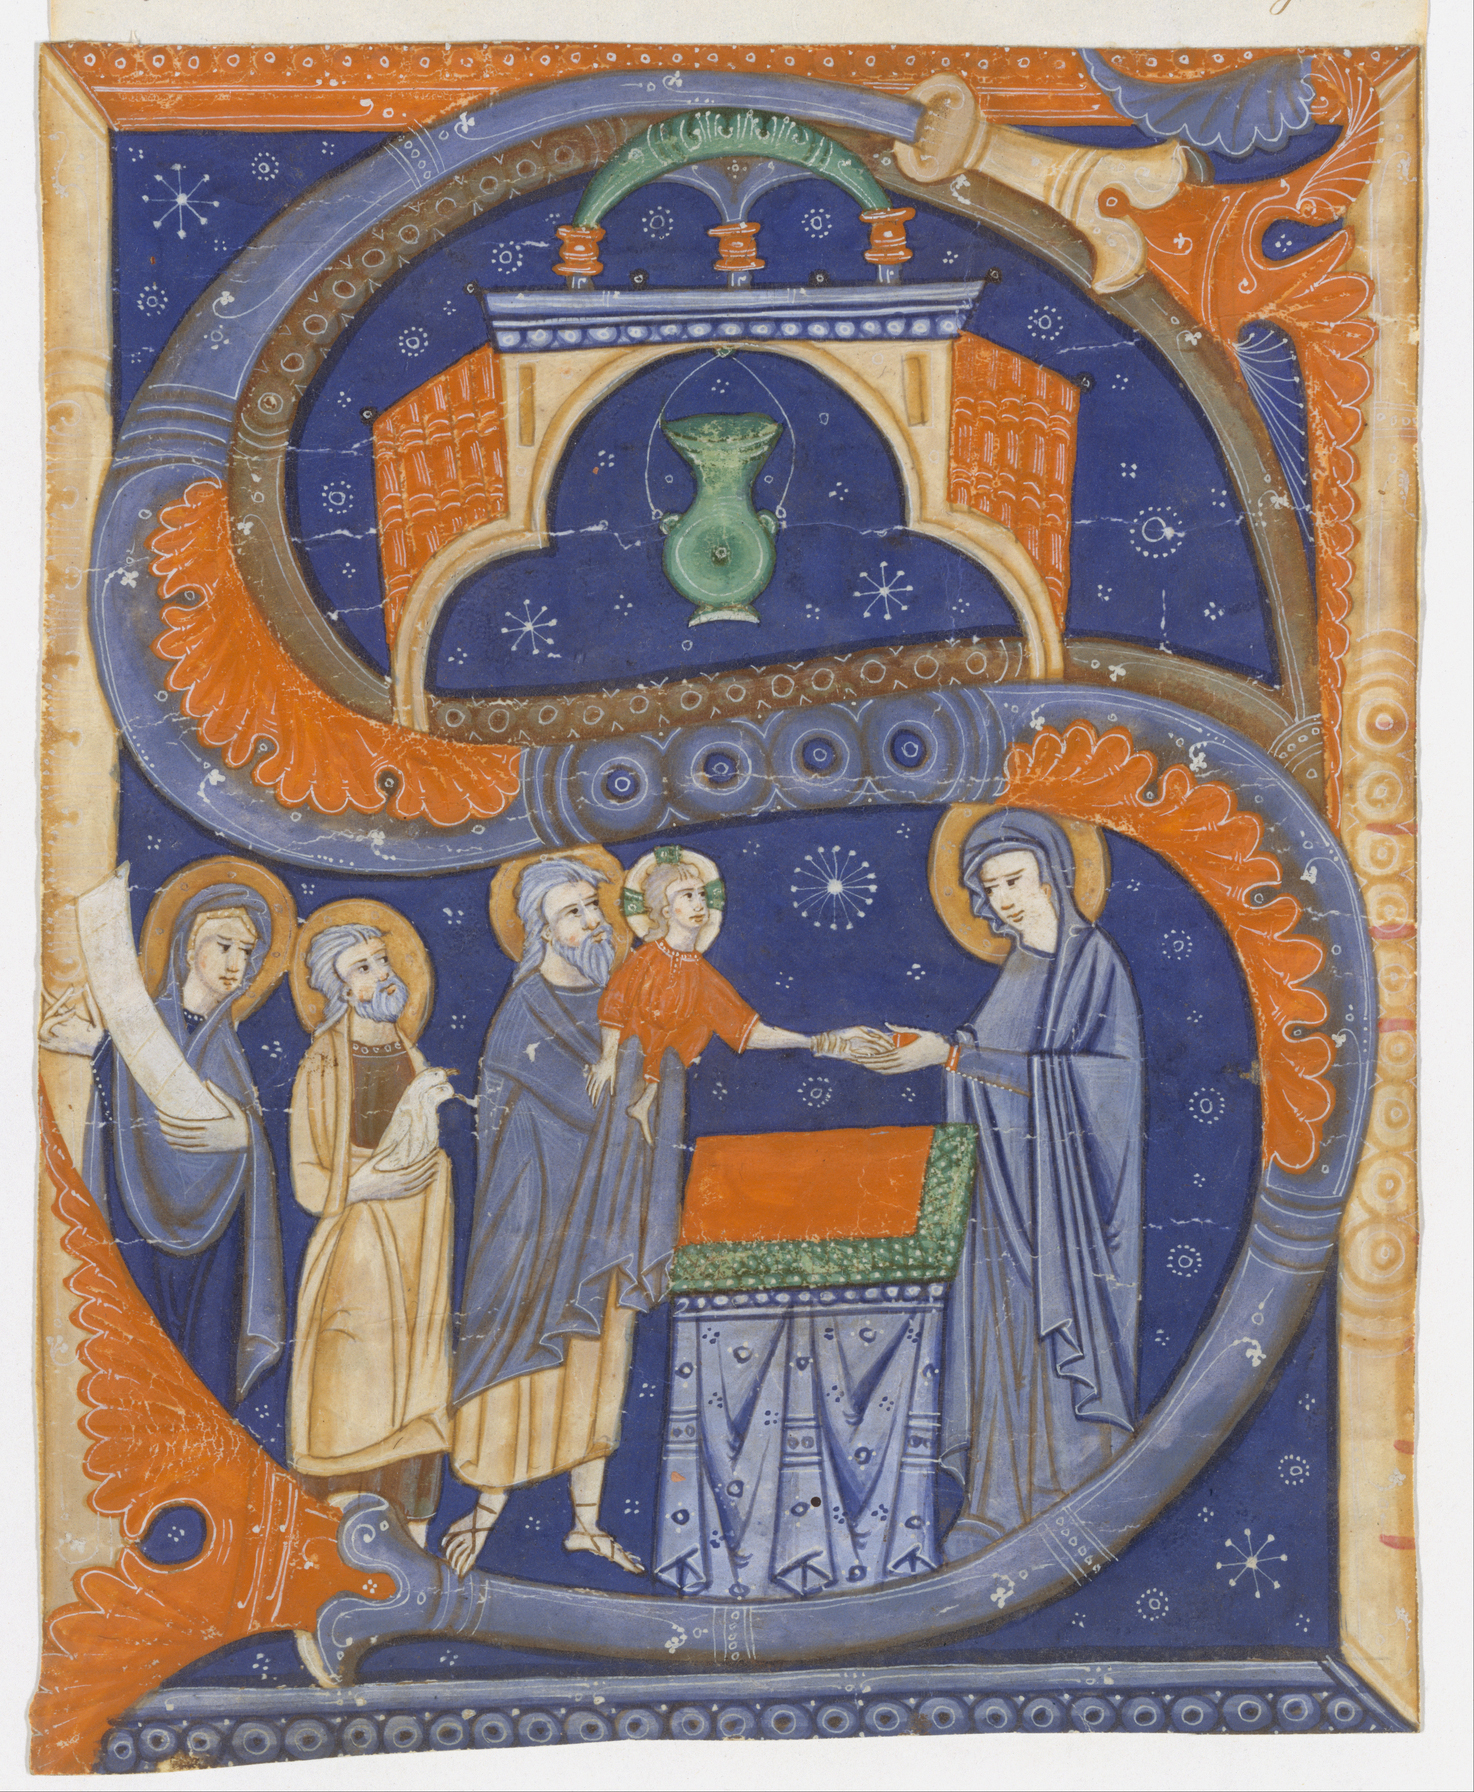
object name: gradual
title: Manuscript Illumination with the Presentation of Christ in the Temple in an Initial S, from a Gradual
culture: italian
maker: master of bagnacavallo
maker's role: artist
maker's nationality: italian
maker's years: 1275-1299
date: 1278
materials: ink, parchment, paint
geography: italy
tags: temples,men,christ,virgin mary